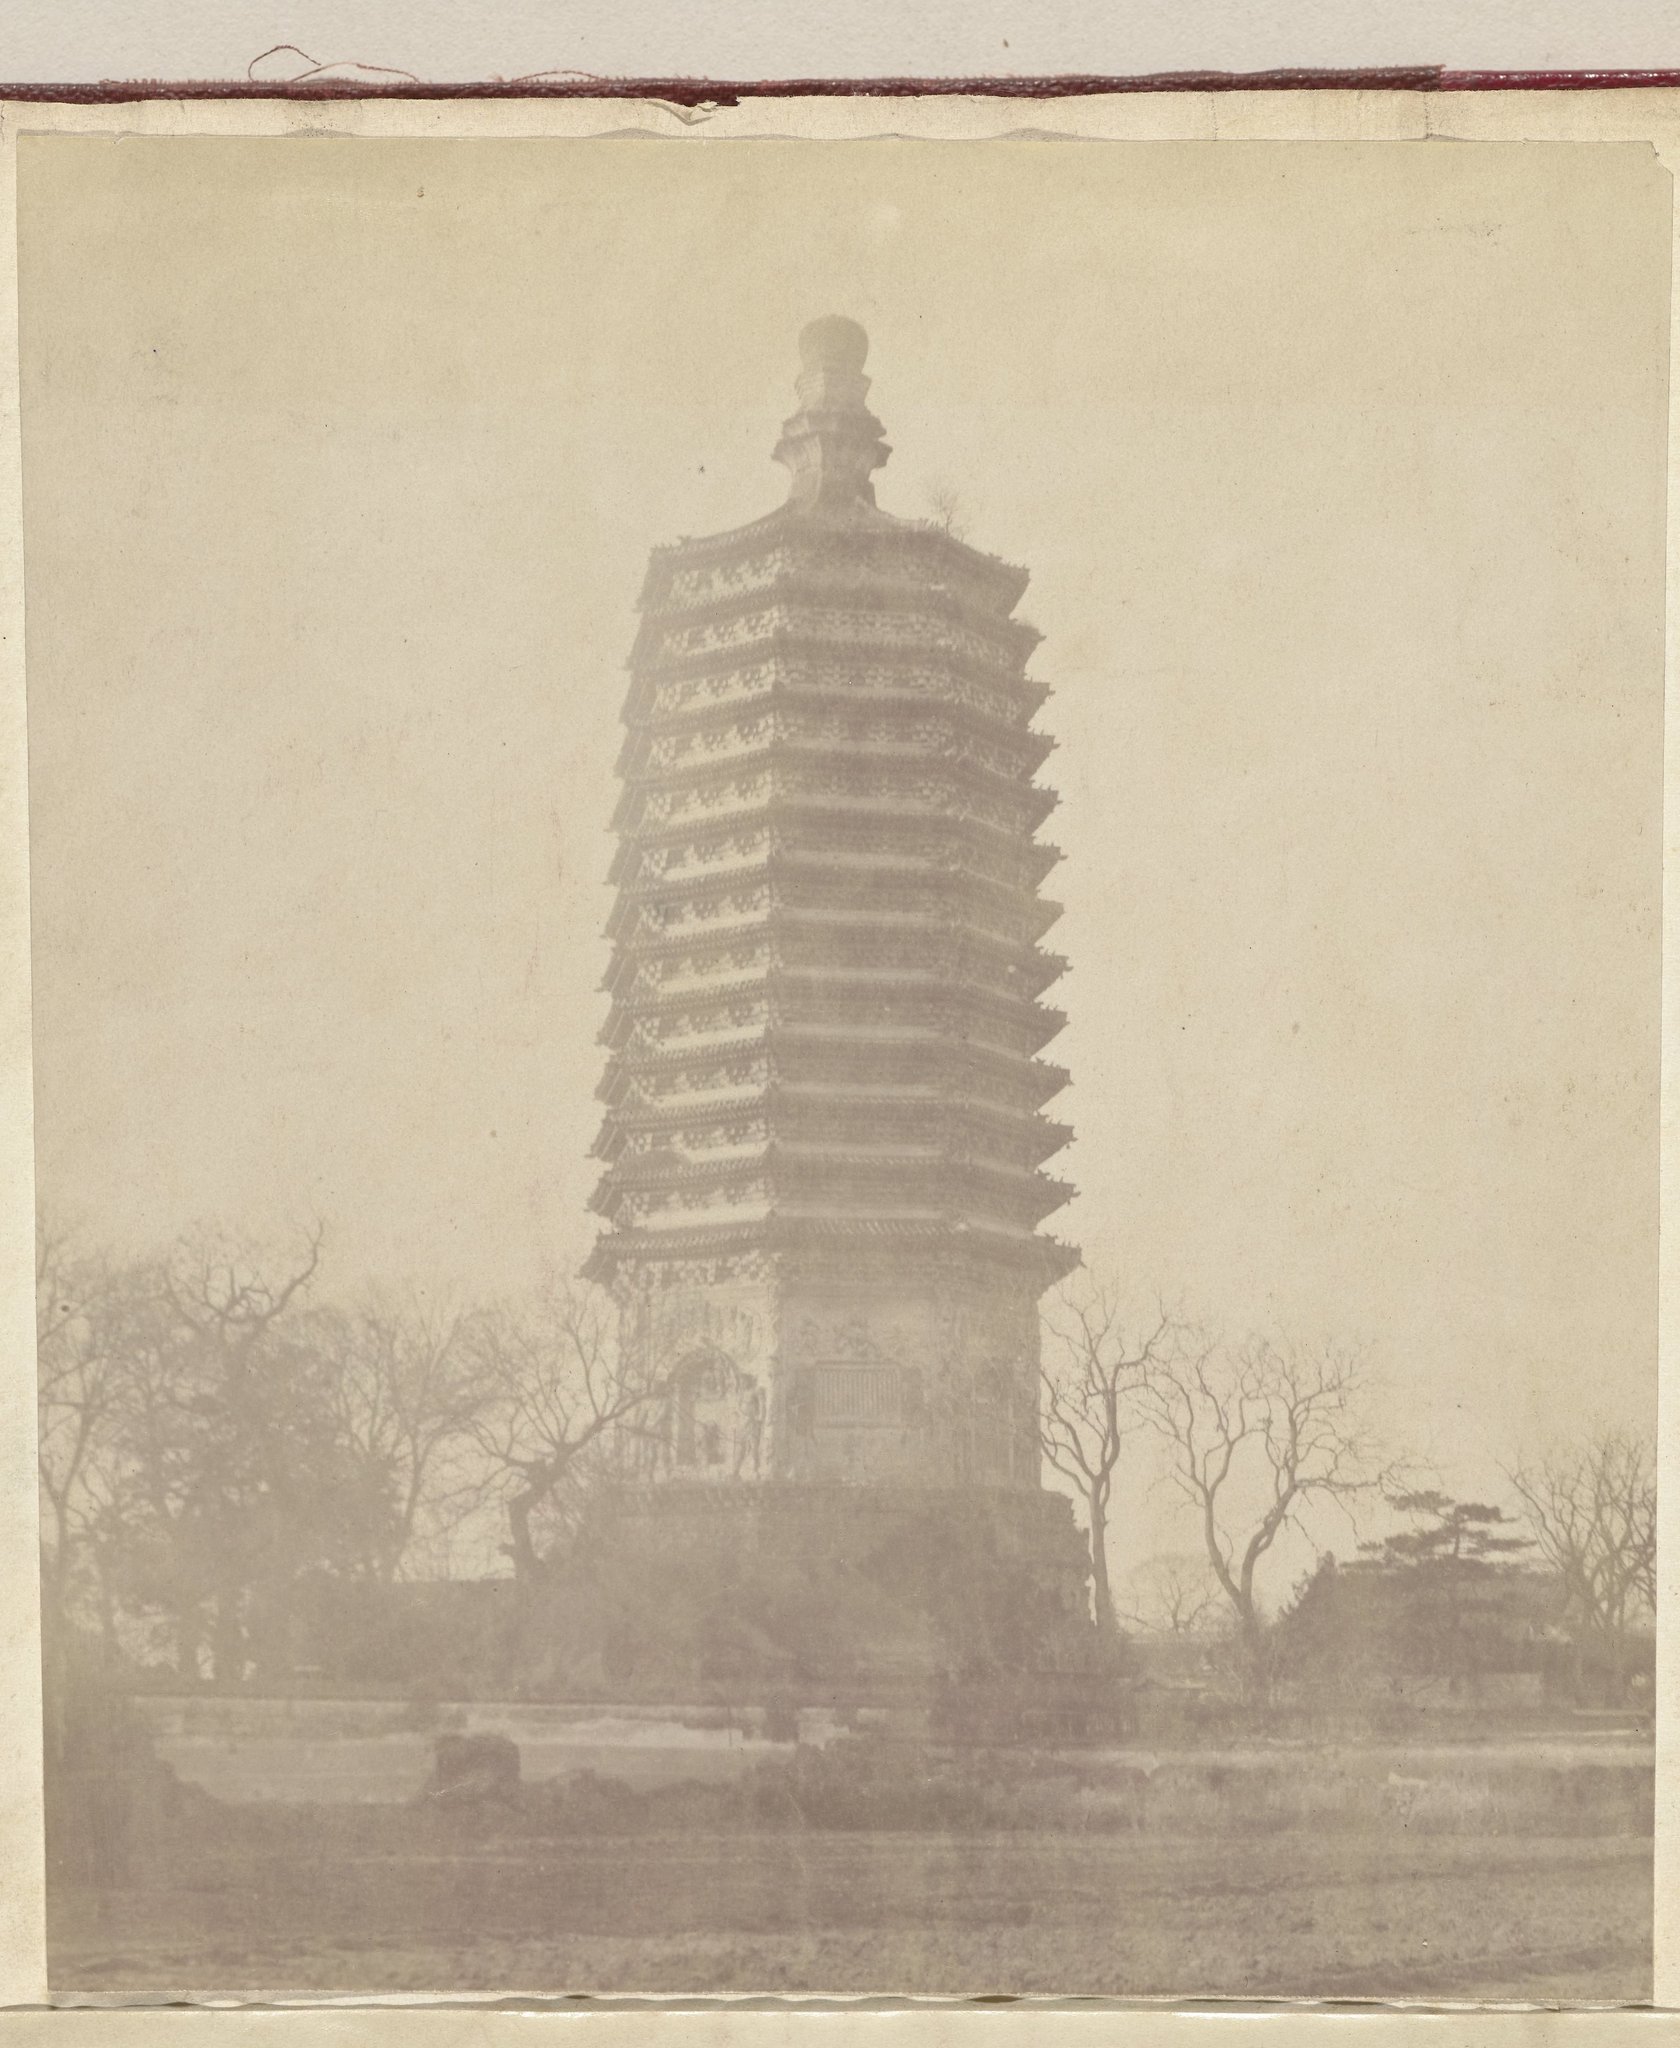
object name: photograph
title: Pagode van de tempel van Tianning, Beijing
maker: Anonymous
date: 1879-1890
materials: paper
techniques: albumen print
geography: china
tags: temple, shrine ~ hinduism, buddhism, jainism